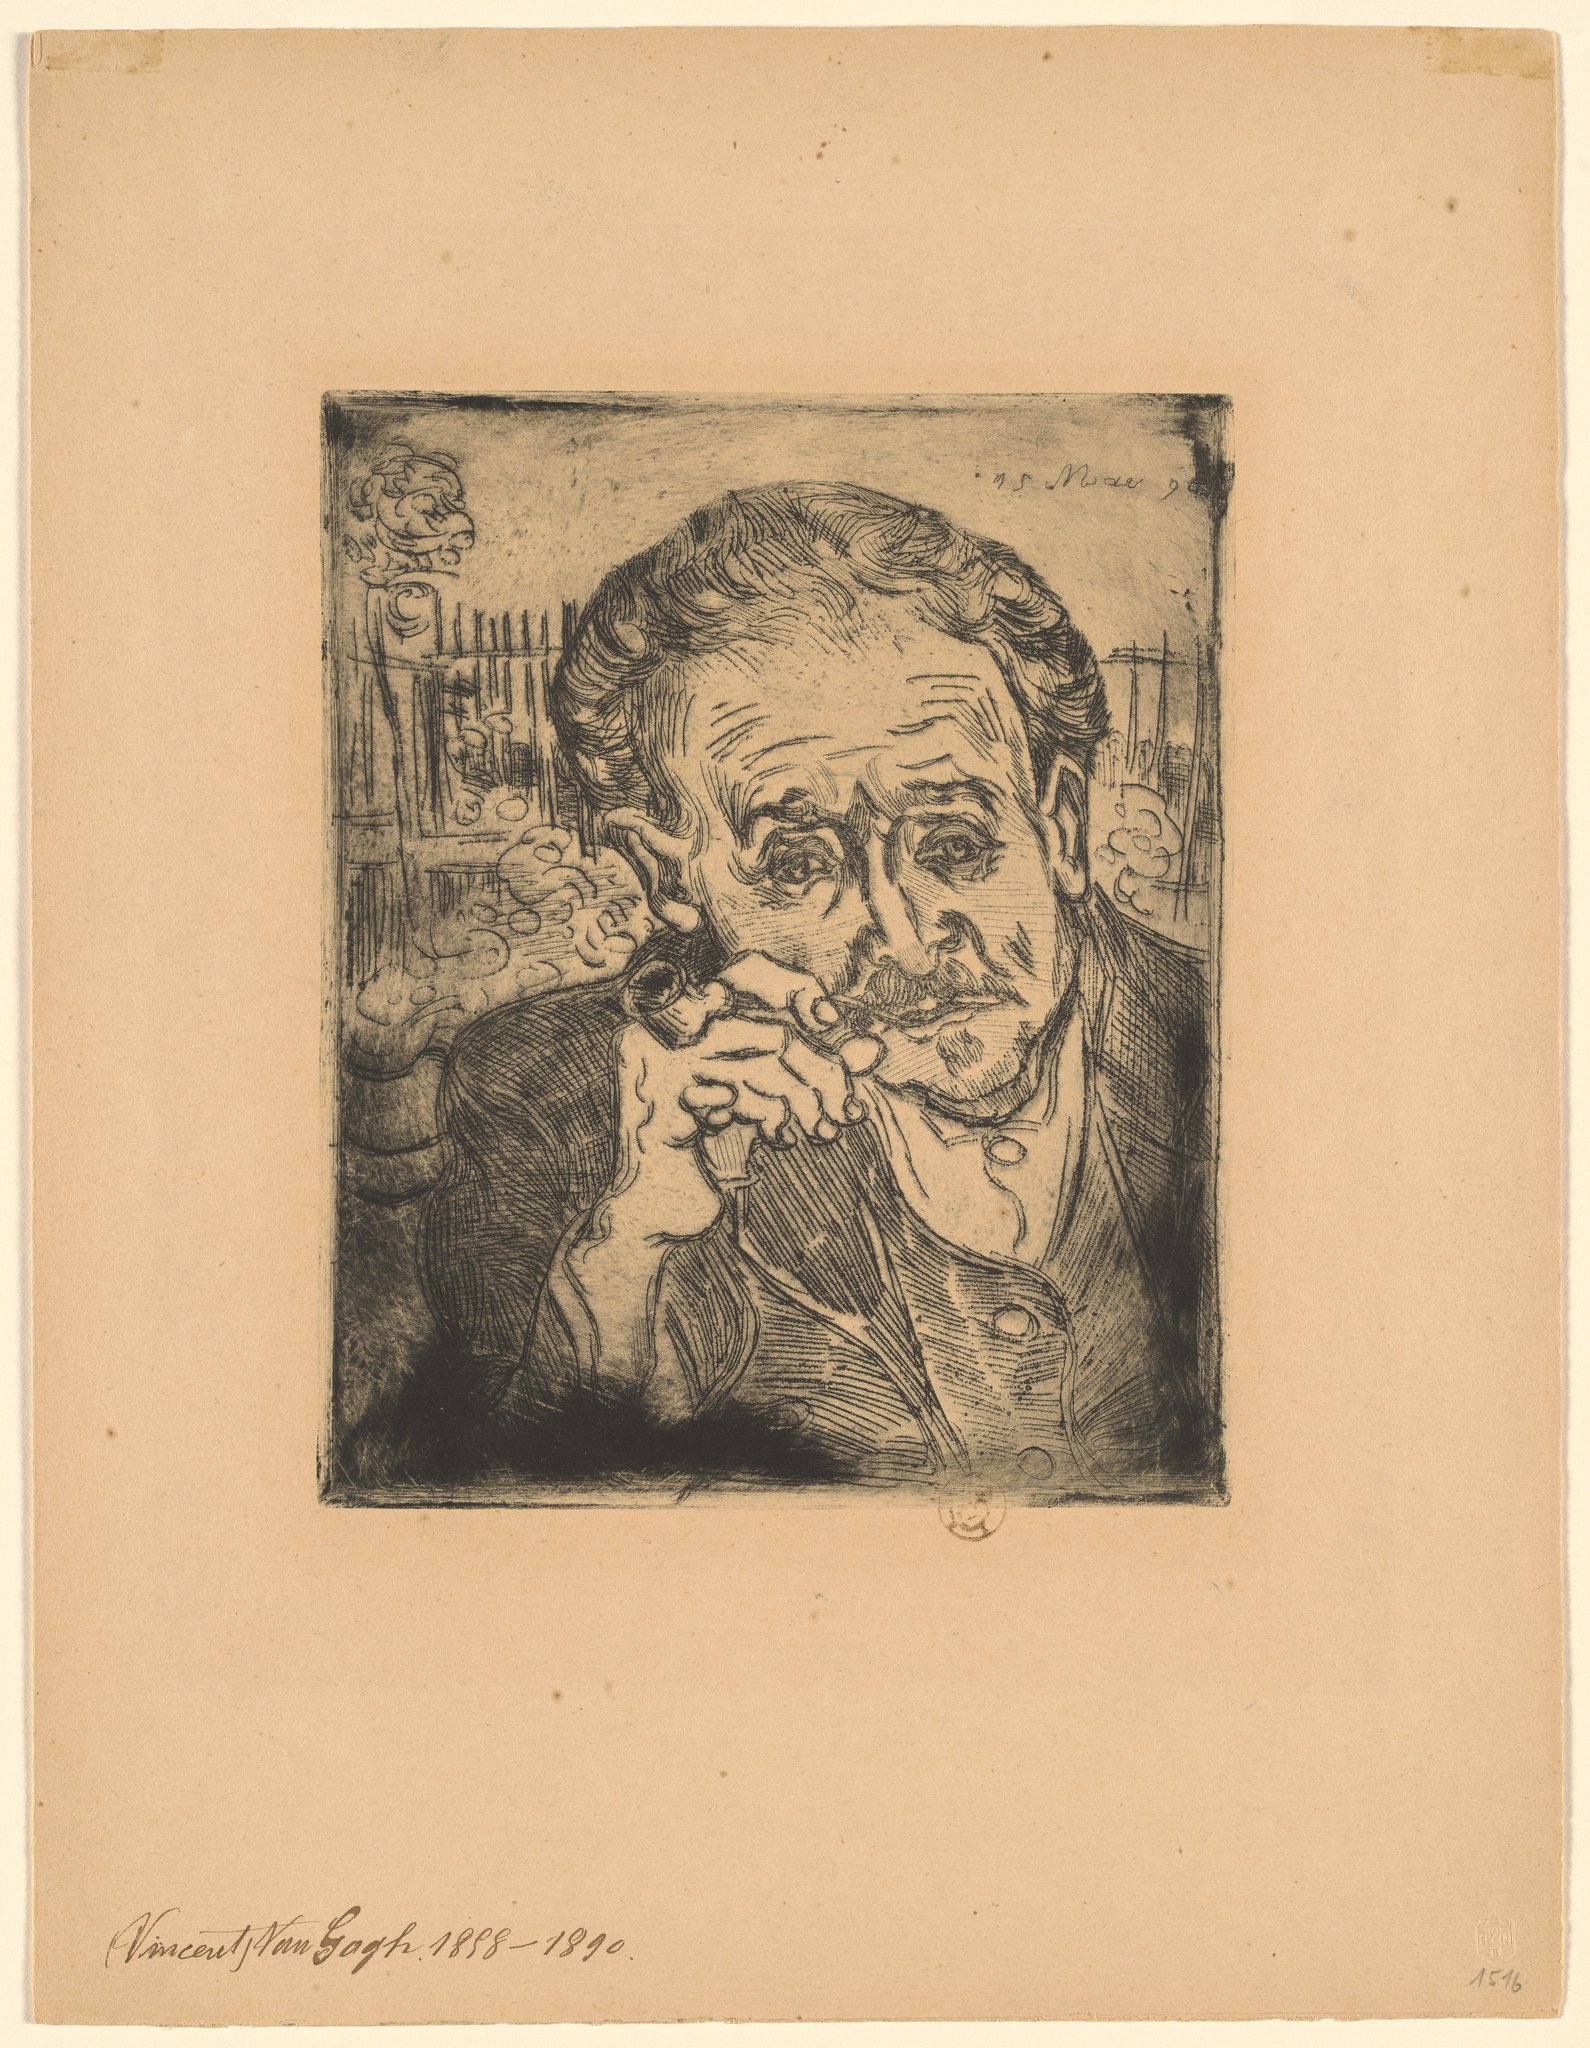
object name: print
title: Portrait of Doctor Gachet or Man with a Pipe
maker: vincent van gogh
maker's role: artist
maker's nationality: dutch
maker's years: 1853-1890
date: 1890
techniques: etching